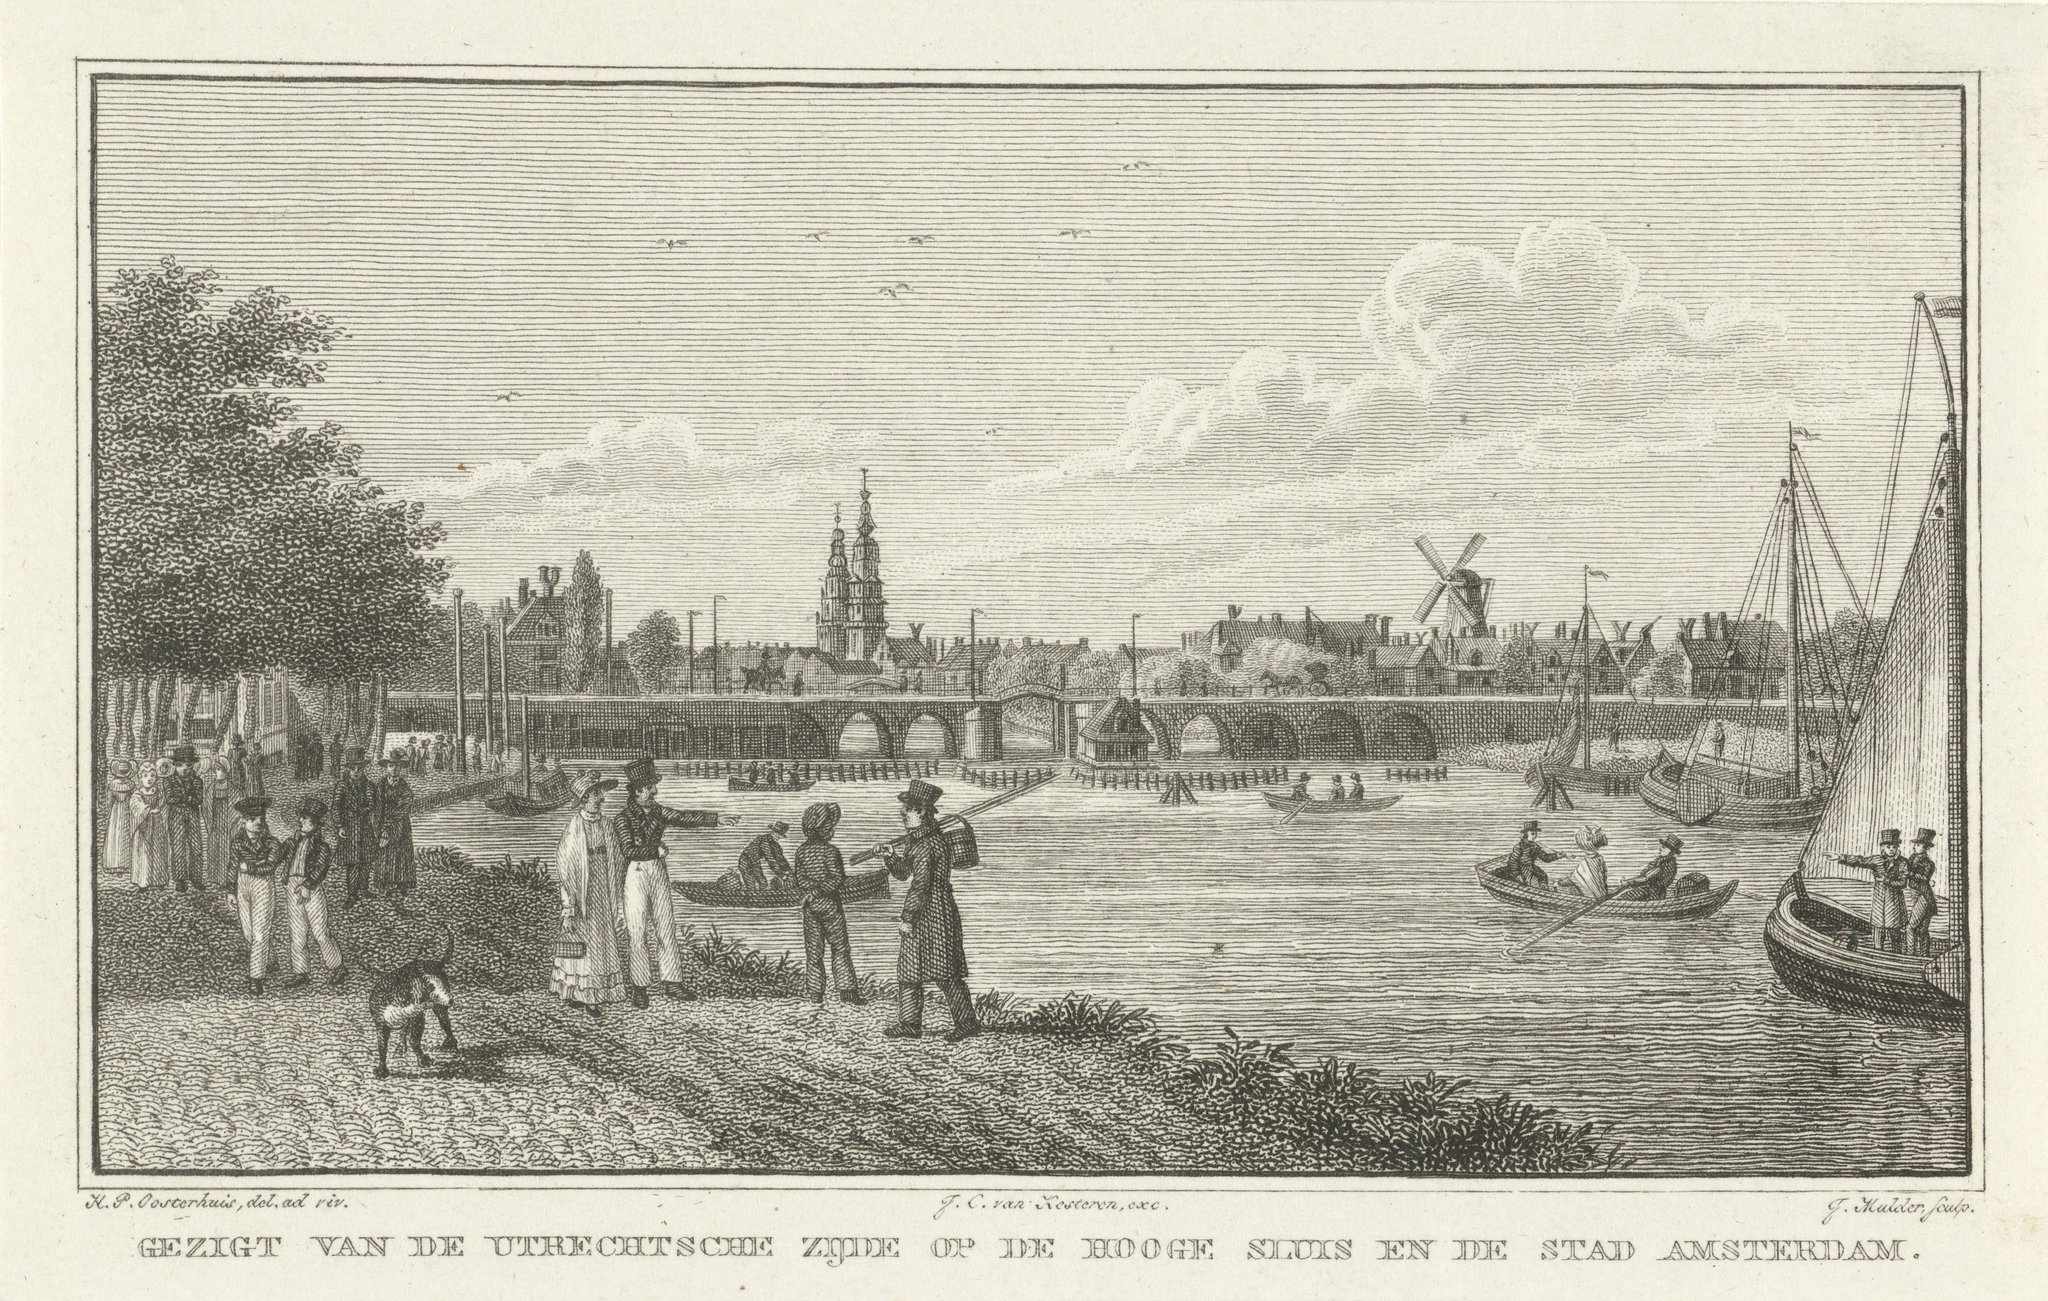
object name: print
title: Gezicht op de Hoge Sluis en de stad Amsterdam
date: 1829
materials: paper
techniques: etching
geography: amsterdam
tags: sluice, weir, sailing-ship, sailing-boat, river, rowing-boat, canoe, etc., amsterdam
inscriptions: collector's mark: Lugt 2228, collector's mark: Lugt 2760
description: Gezicht op de Hoge Sluis over de Amstel en op de achtergrond de stad Amsterdam. Links op de oever wandelaars. Op het water zeilschepen en een roeiboot.